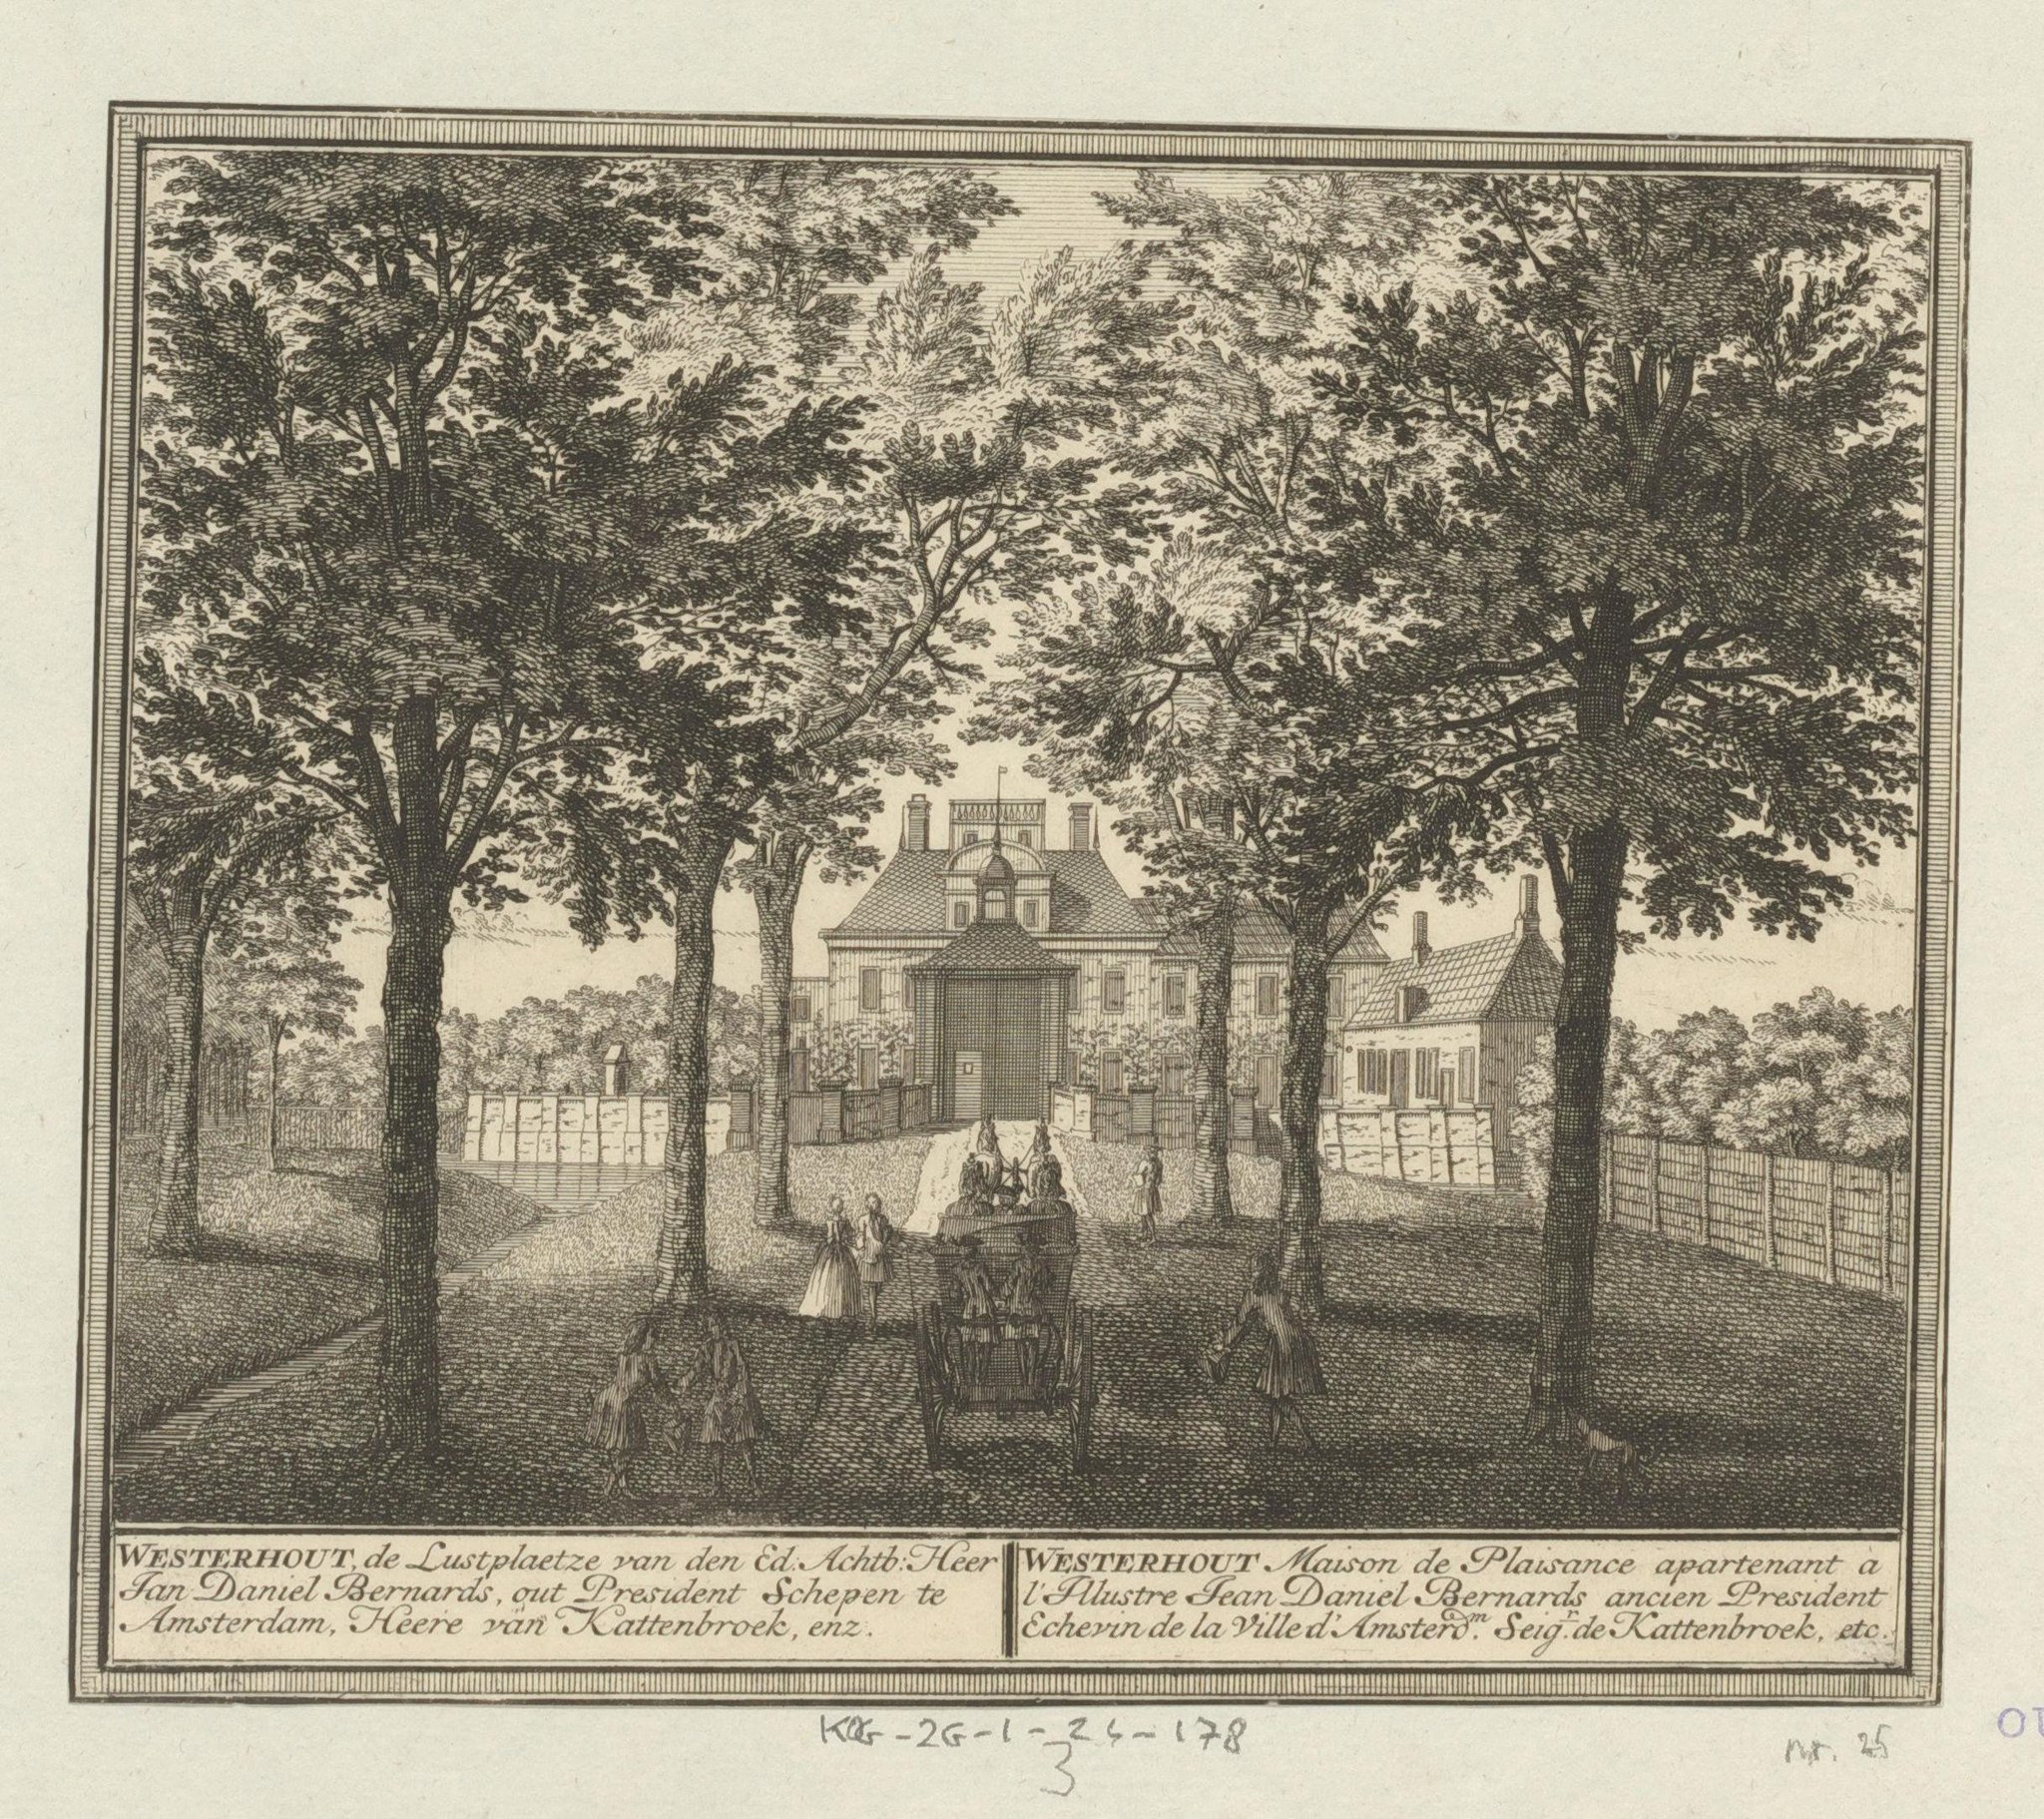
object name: print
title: Westerhout, de Lustplaetze van den Ed. Achtb. Heer Jan Daniel Bernards (...) / Westerhout Maison de Plaisance apartenant à l'Illustre Jean Daniel Bernards (...)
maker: hendrik de leth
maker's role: draughtsman, print maker, publisher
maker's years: 1703-1766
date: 1729-1732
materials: paper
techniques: engraving, etching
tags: animal traction, animal-drawn vehicle (carriage etc.), french or architectonic garden; formal garden, country-house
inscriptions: collector's mark: Lugt 1641, stamp, stamp, stamp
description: Prent mogelijk uit: Brouërius van Nidek, Matthaeus. Het zegepralend Kennemerland, vertoond in 100 heerlyke gezichten. Amsterdam: Jan Roman, s.a. Of uit: Brouërius van Nidek, Matthaeus. Het zegepralend Kennemerland, vertoond in veele heerlyke gezichten. Amsterdam: Andries en Hendrik de Leth, s.a [1729-1732]. Of uit: Brouërius van Nidek, Matthaeus. Het zegepralend Kennemerland, vertoond in veele heerlyke gezichten. Amsterdam: Jan Roman, s.a.